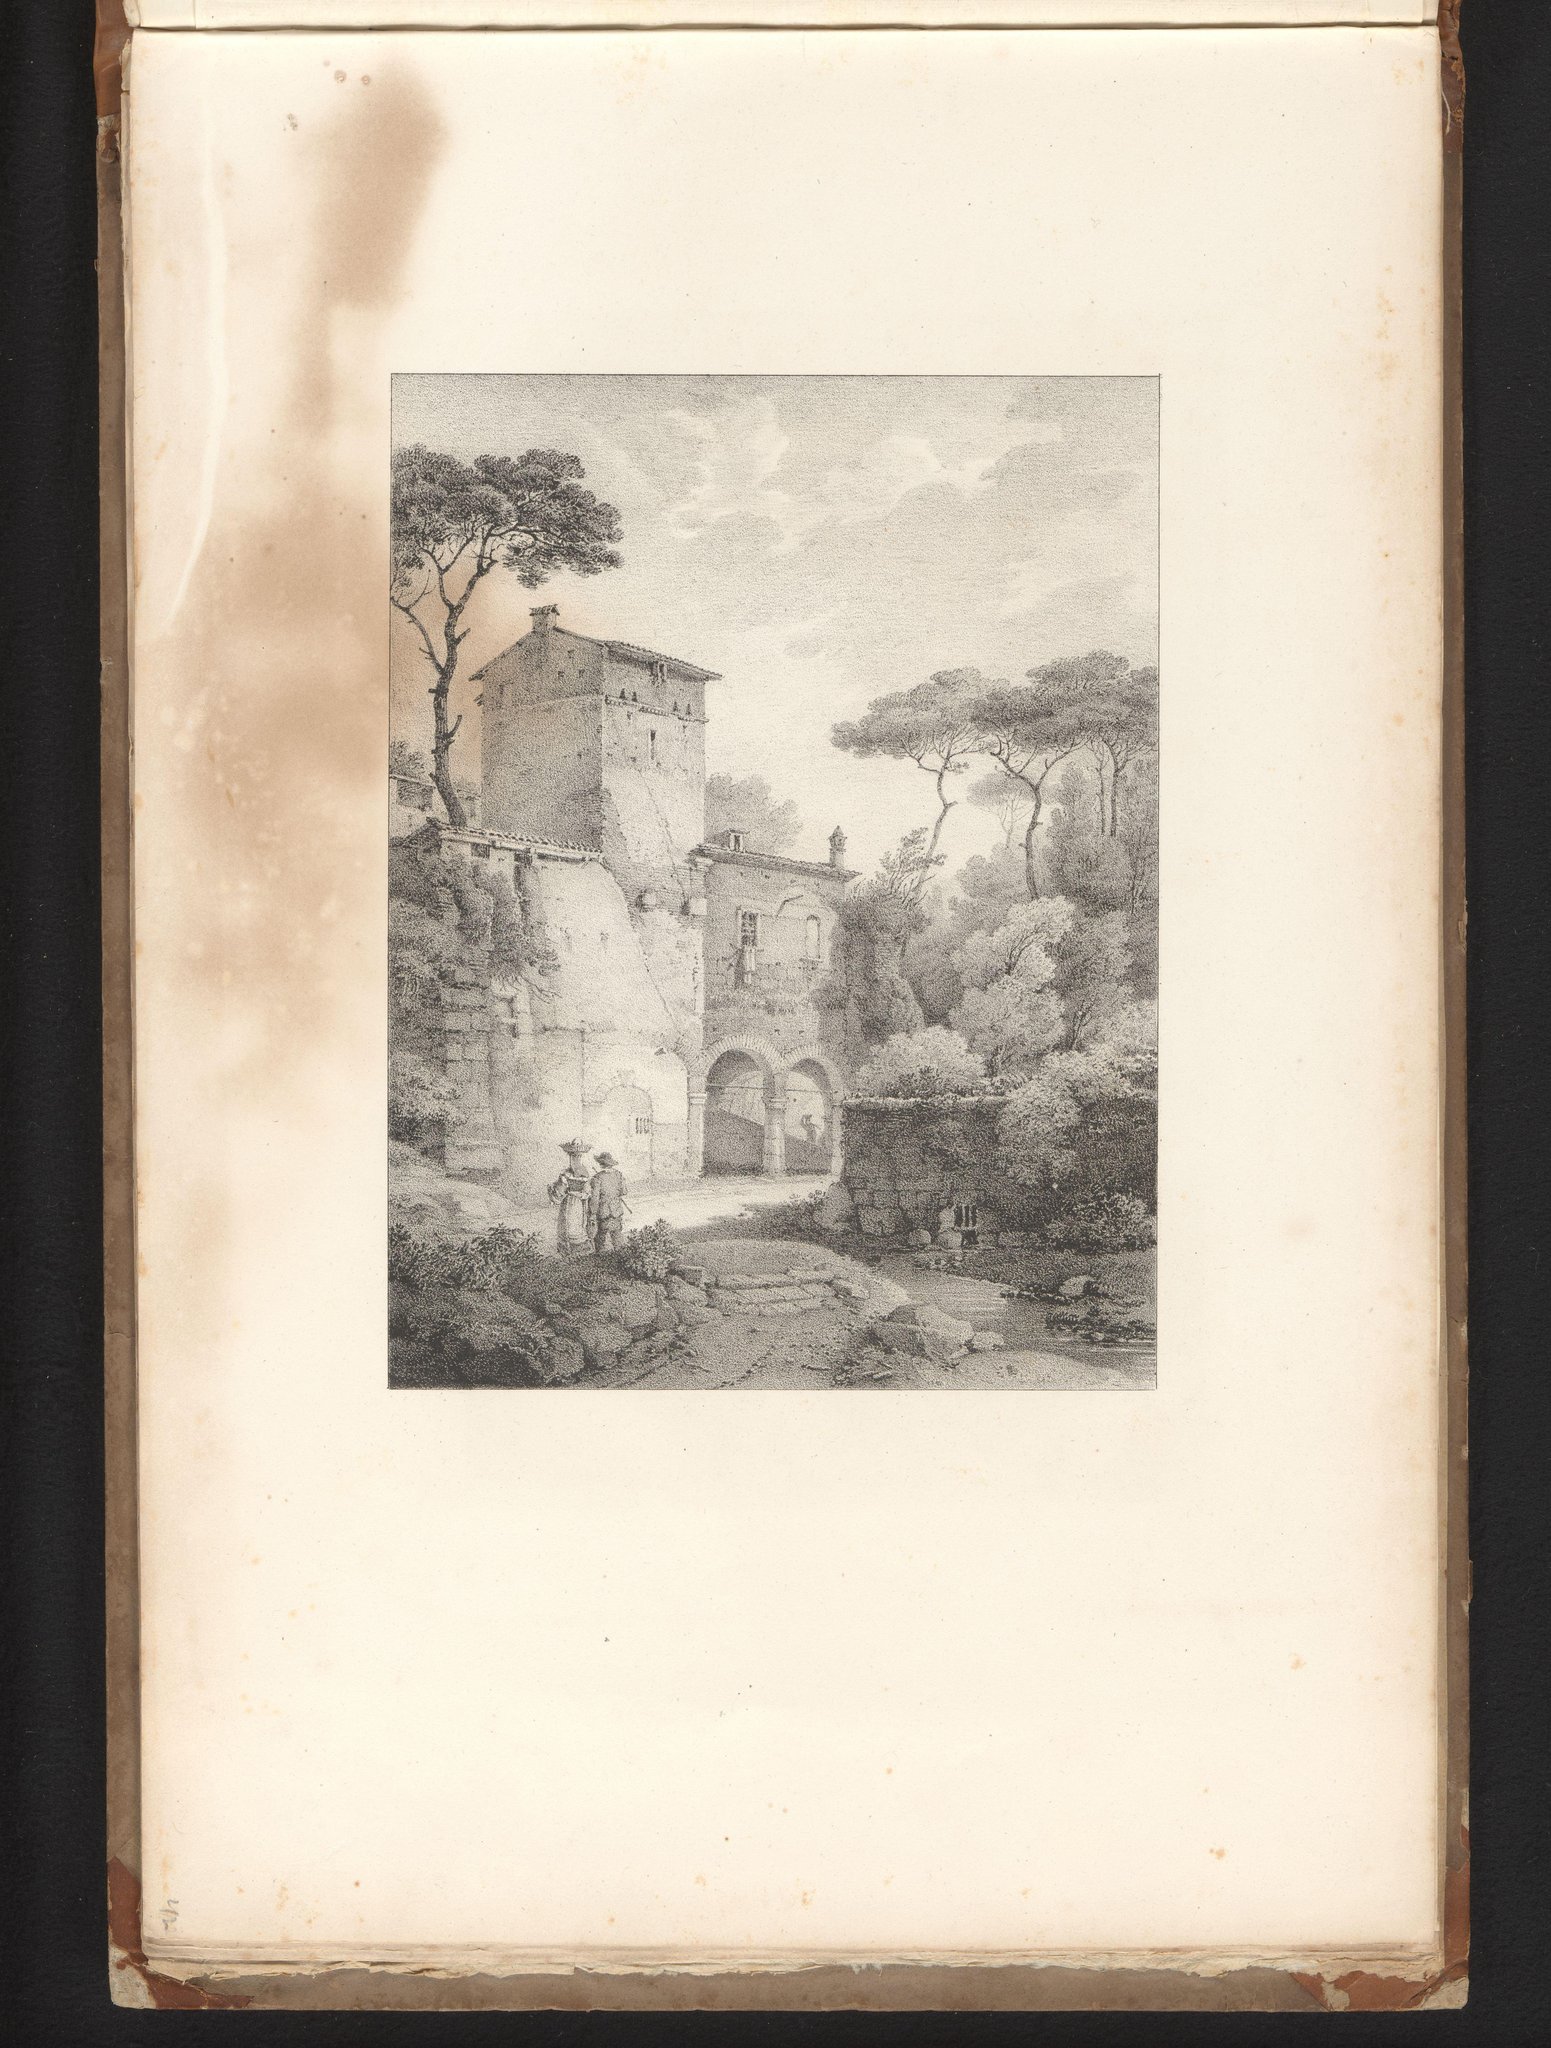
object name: album leaf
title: Landschap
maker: Anonymous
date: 1818-1819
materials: paper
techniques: lithograph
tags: city-view, and landscape with man-made constructions